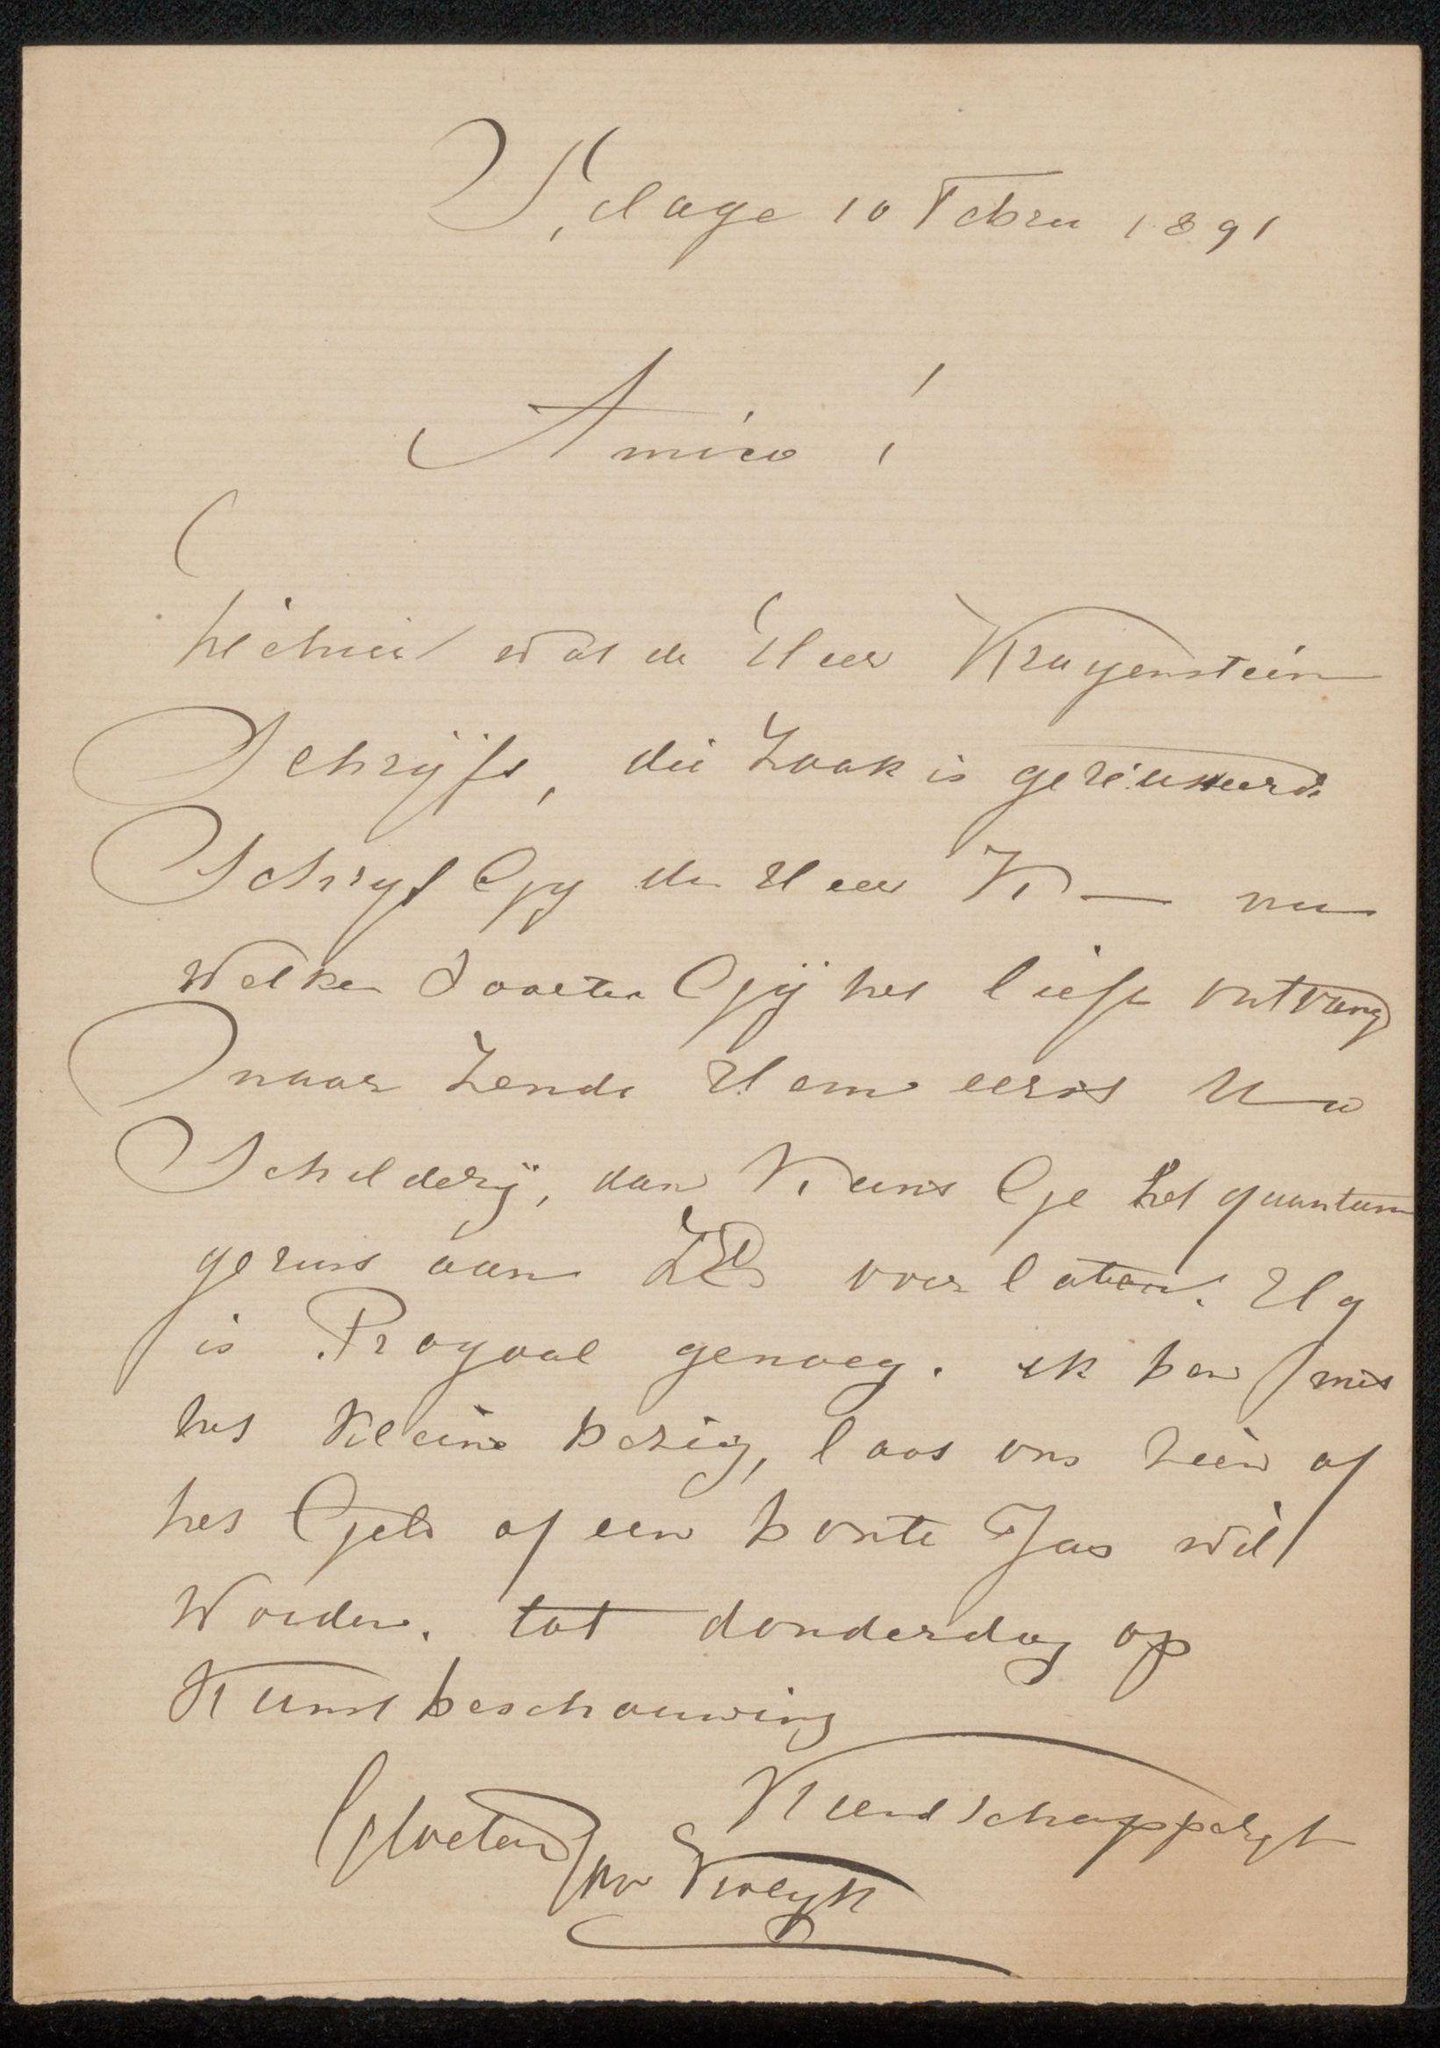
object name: letter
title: Brief aan Philip Zilcken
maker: jan vrolijk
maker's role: draughtsman, painter, print maker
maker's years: 1846-1894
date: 1891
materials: ink, paper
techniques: pen, writing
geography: the hague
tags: the hague, painter, philip zilcken, criticizing and discussing art, art criticism, painting (including book-illumination, miniature-painting)